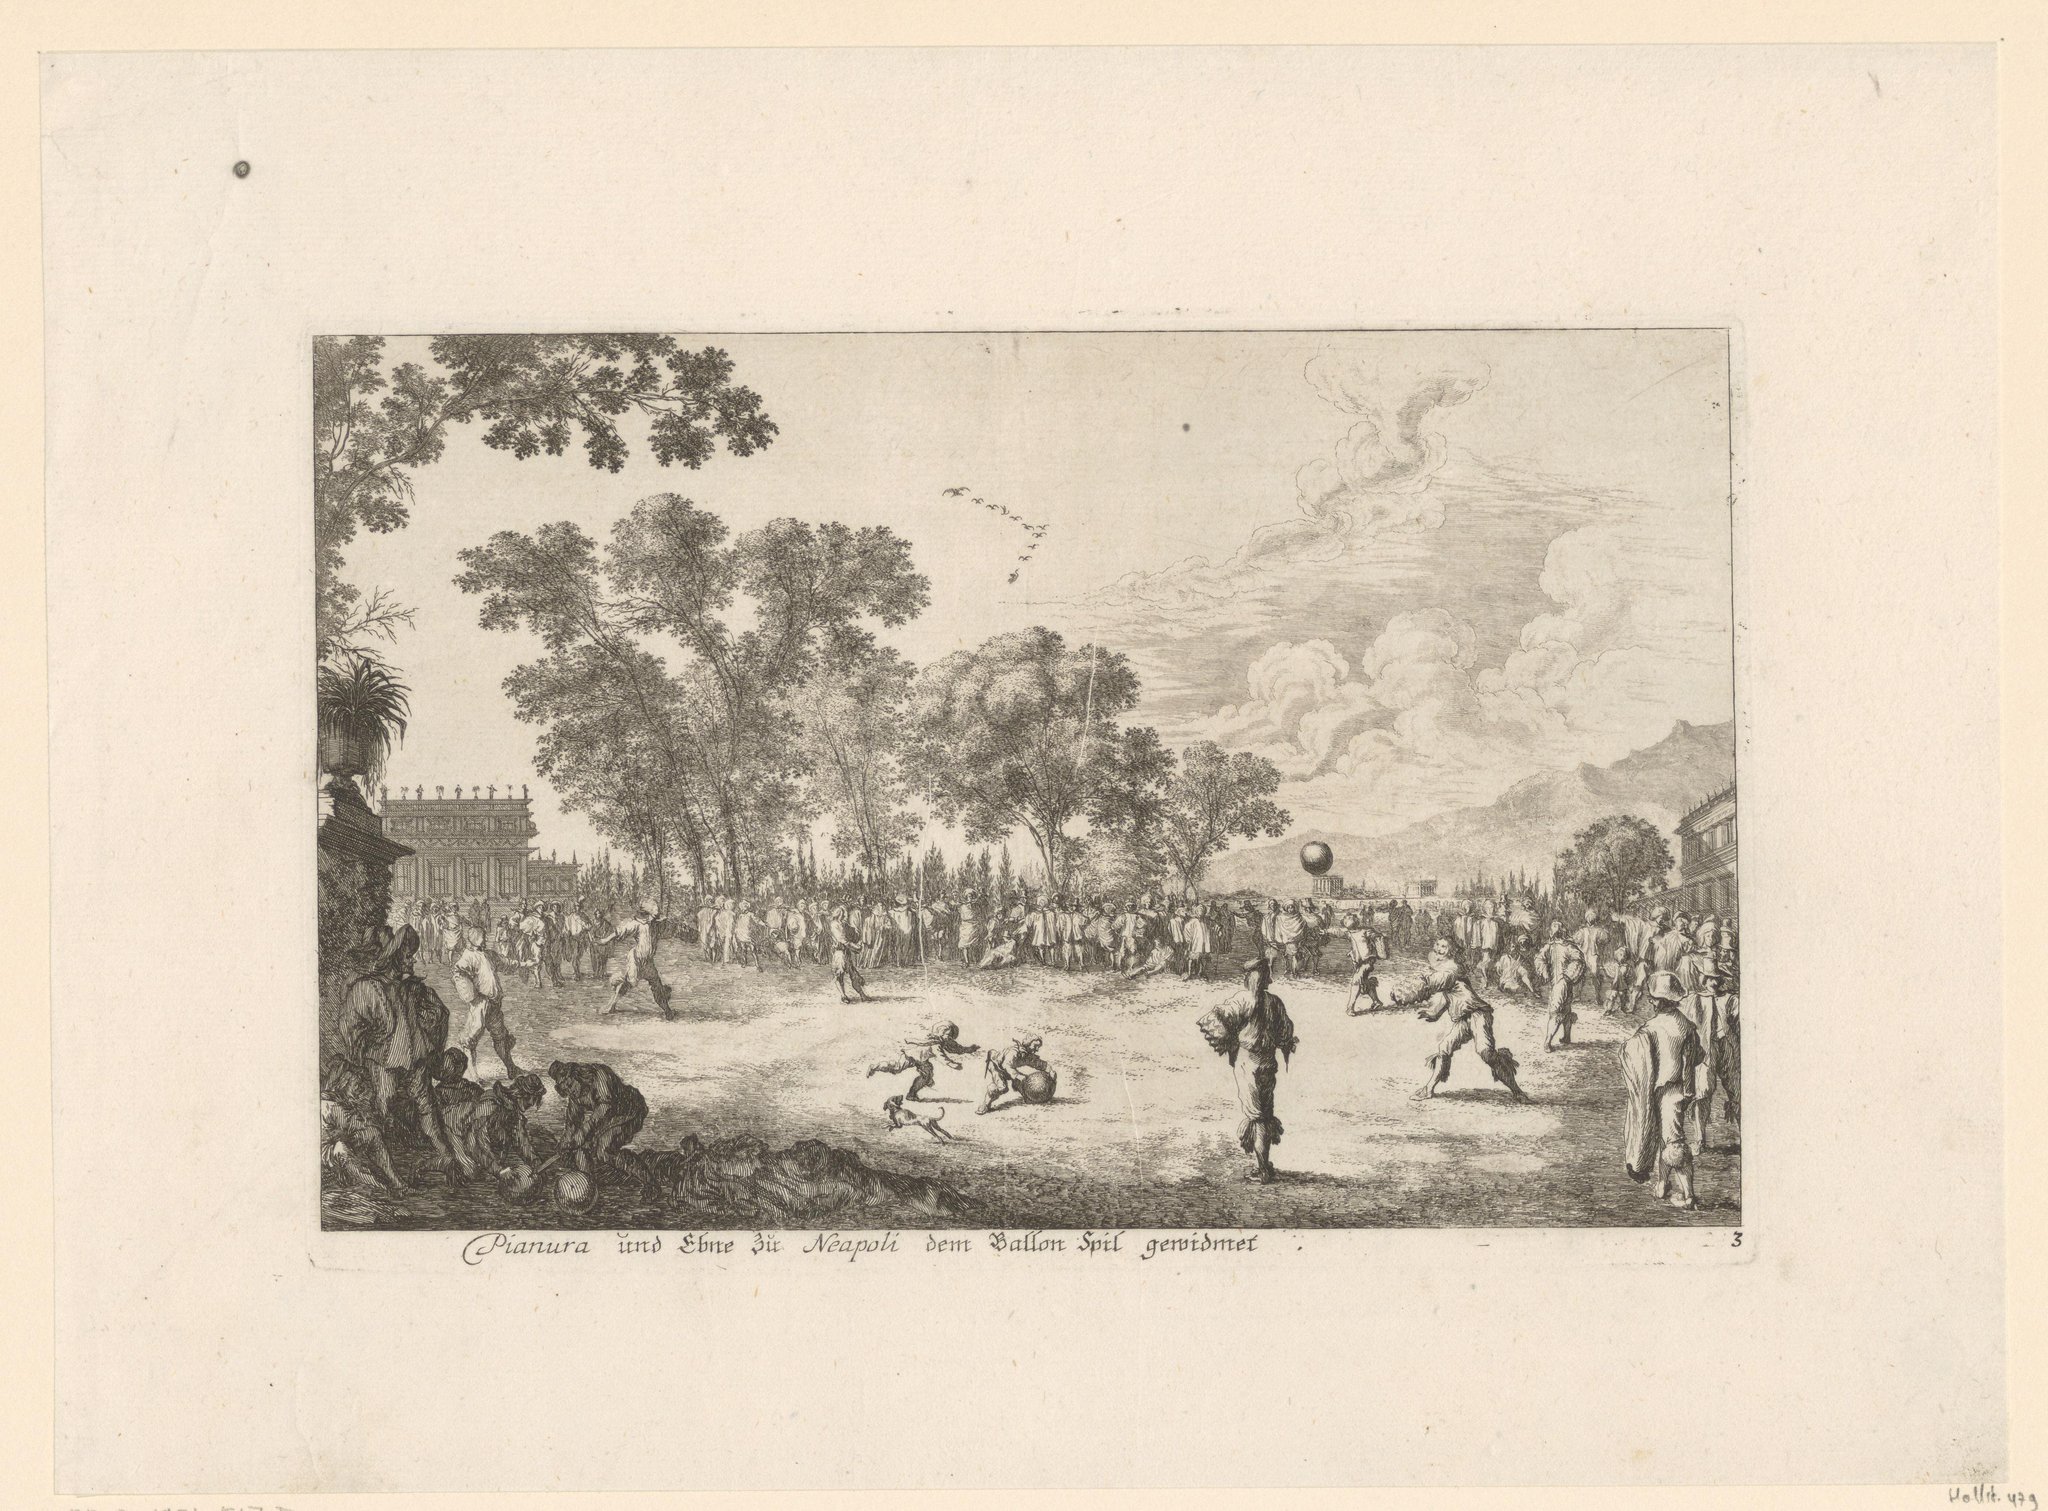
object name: print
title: Mooie en waarachtige landschappen uit Italië en andere landen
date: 1670-1719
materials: paper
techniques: etching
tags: ball games in which hands are used (team play), civic architecture; edifices; dwellings, ball games in which ball is hit with racket (or hand)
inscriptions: collector's mark: Lugt 2228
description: Deze prent is deel van de serie: Schöne und Wahre Landschafften in Italien und andern Landern. Augsburg: Johann Ulrich Kraus, 1675-1685. De serie bestaat uit veertien prenten plus een titelprent. Deze uitgave omvat een selectie van de 146 prenten uit de uitgave getiteld 'Joannis Guilielmi Baurn Iconographia completens in se, Passionem (...) Per Italiam, Spectatu Sunt', voor het eerst uitgegeven in Augsburg in 1670.